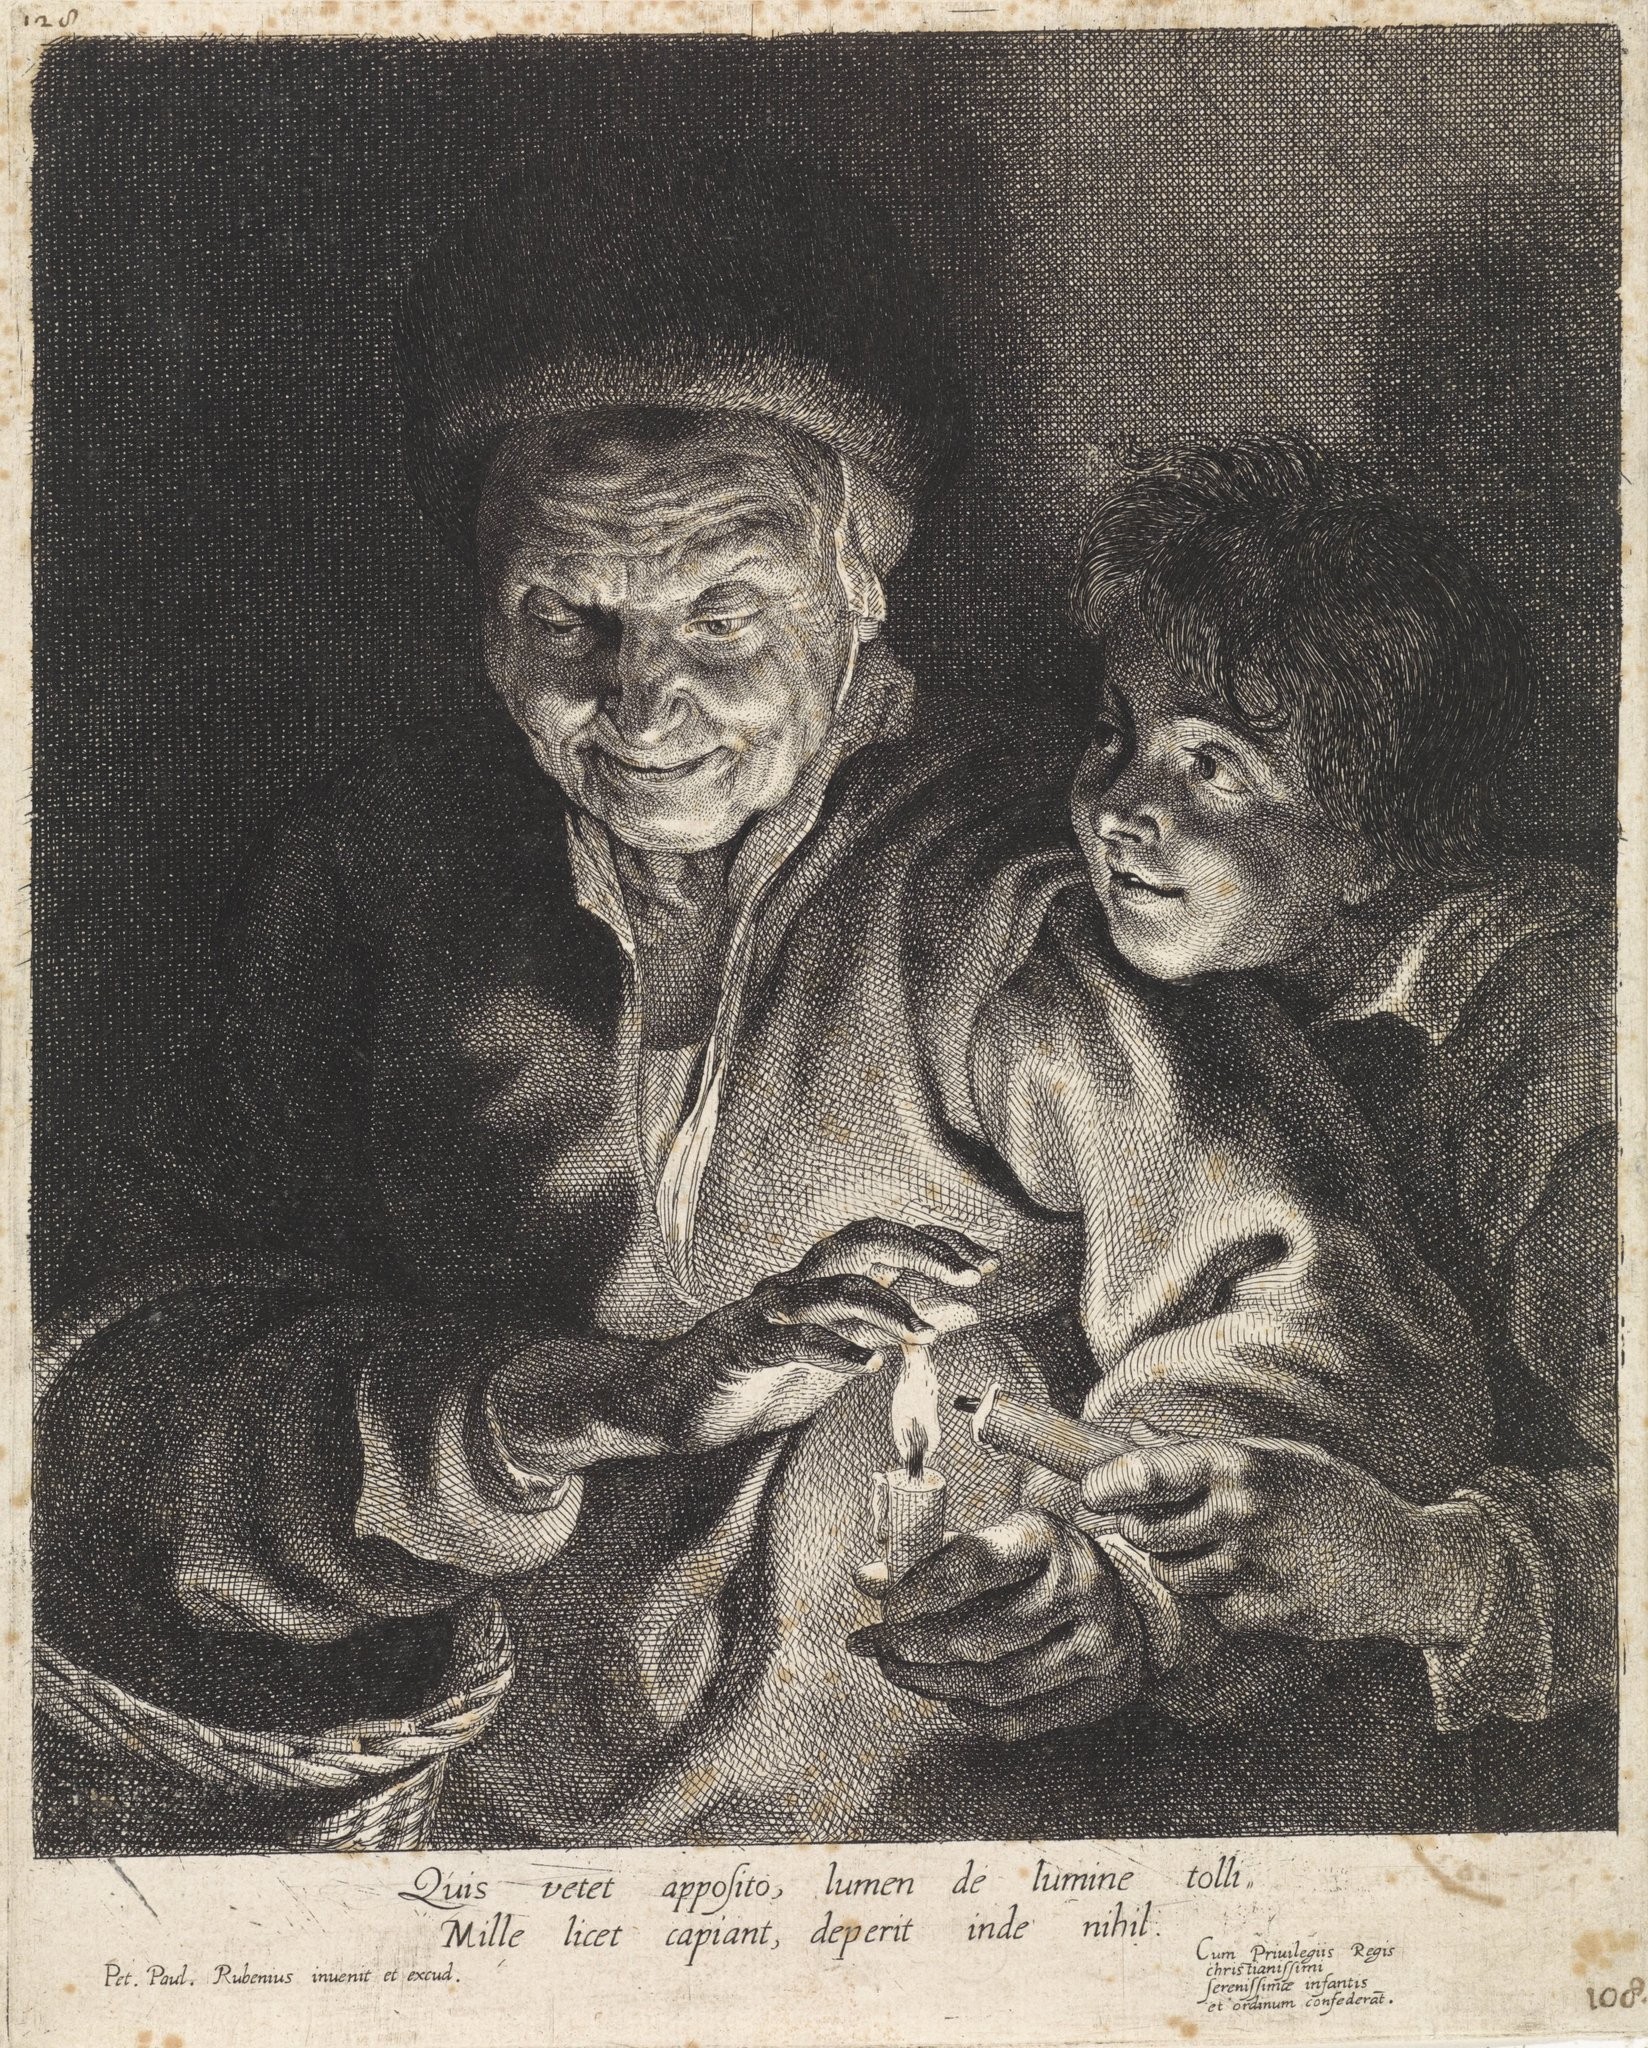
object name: print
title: Oude vrouw en jongen met kaarsen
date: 1616-1657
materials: paper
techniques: engraving, etching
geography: antwerp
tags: scenes symbolizing 'vanitas', candle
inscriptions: number: ‘108.’, collector's mark: Lugt 240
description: Een jongen neemt met zijn kaars de vlam over van de kaars van de oude vrouw. In de marge een tweeregelig onderschrift in het Latijn.